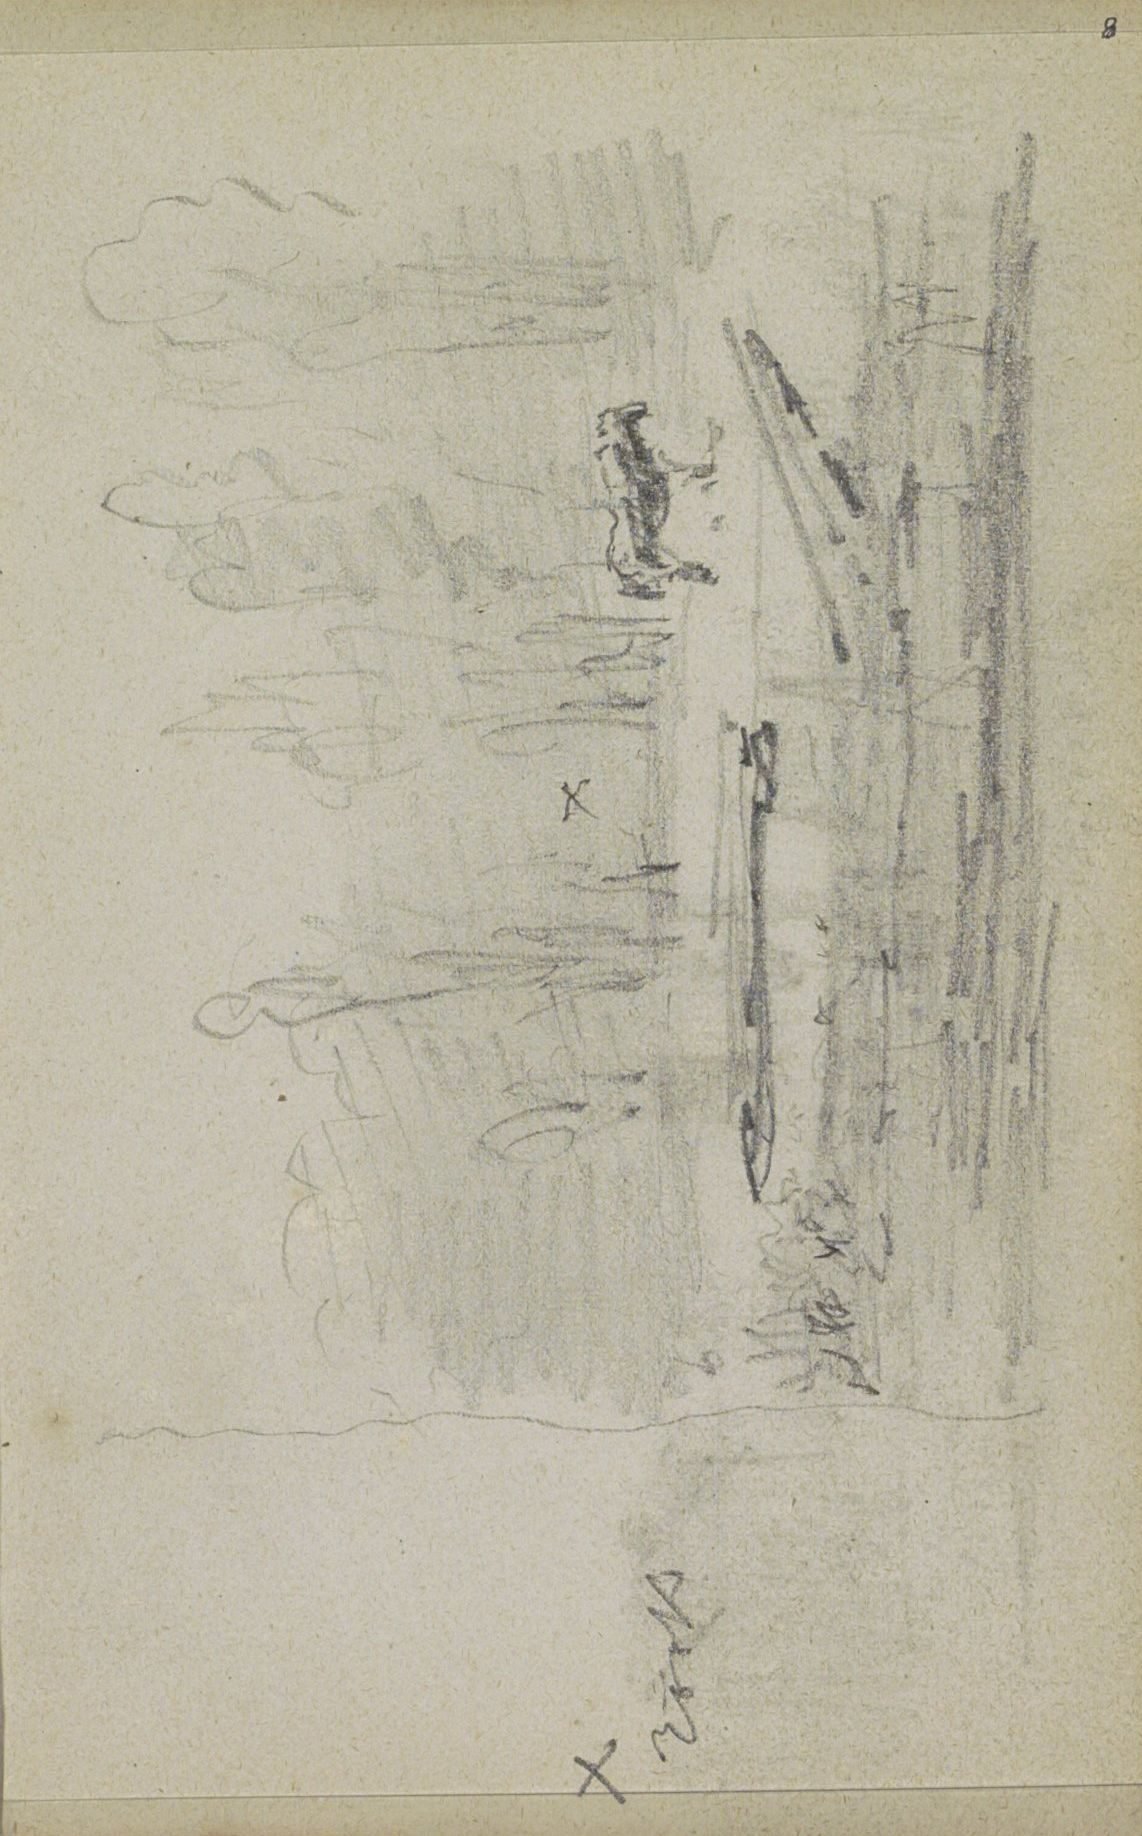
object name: sketchbook leaf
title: Paard in een landschap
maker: adrianus eversen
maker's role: draughtsman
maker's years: 1818-1897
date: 1828-1897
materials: paper, pencil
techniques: stumping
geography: netherlands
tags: landscapes with waters, waterscapes, seascapes (in the temperate zone), horse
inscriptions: kleurnotitie, handgeschreven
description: Landschap met een paard. Vooraan mogelijk water. Blad 8 recto uit een schetsboek met 58 bladen.